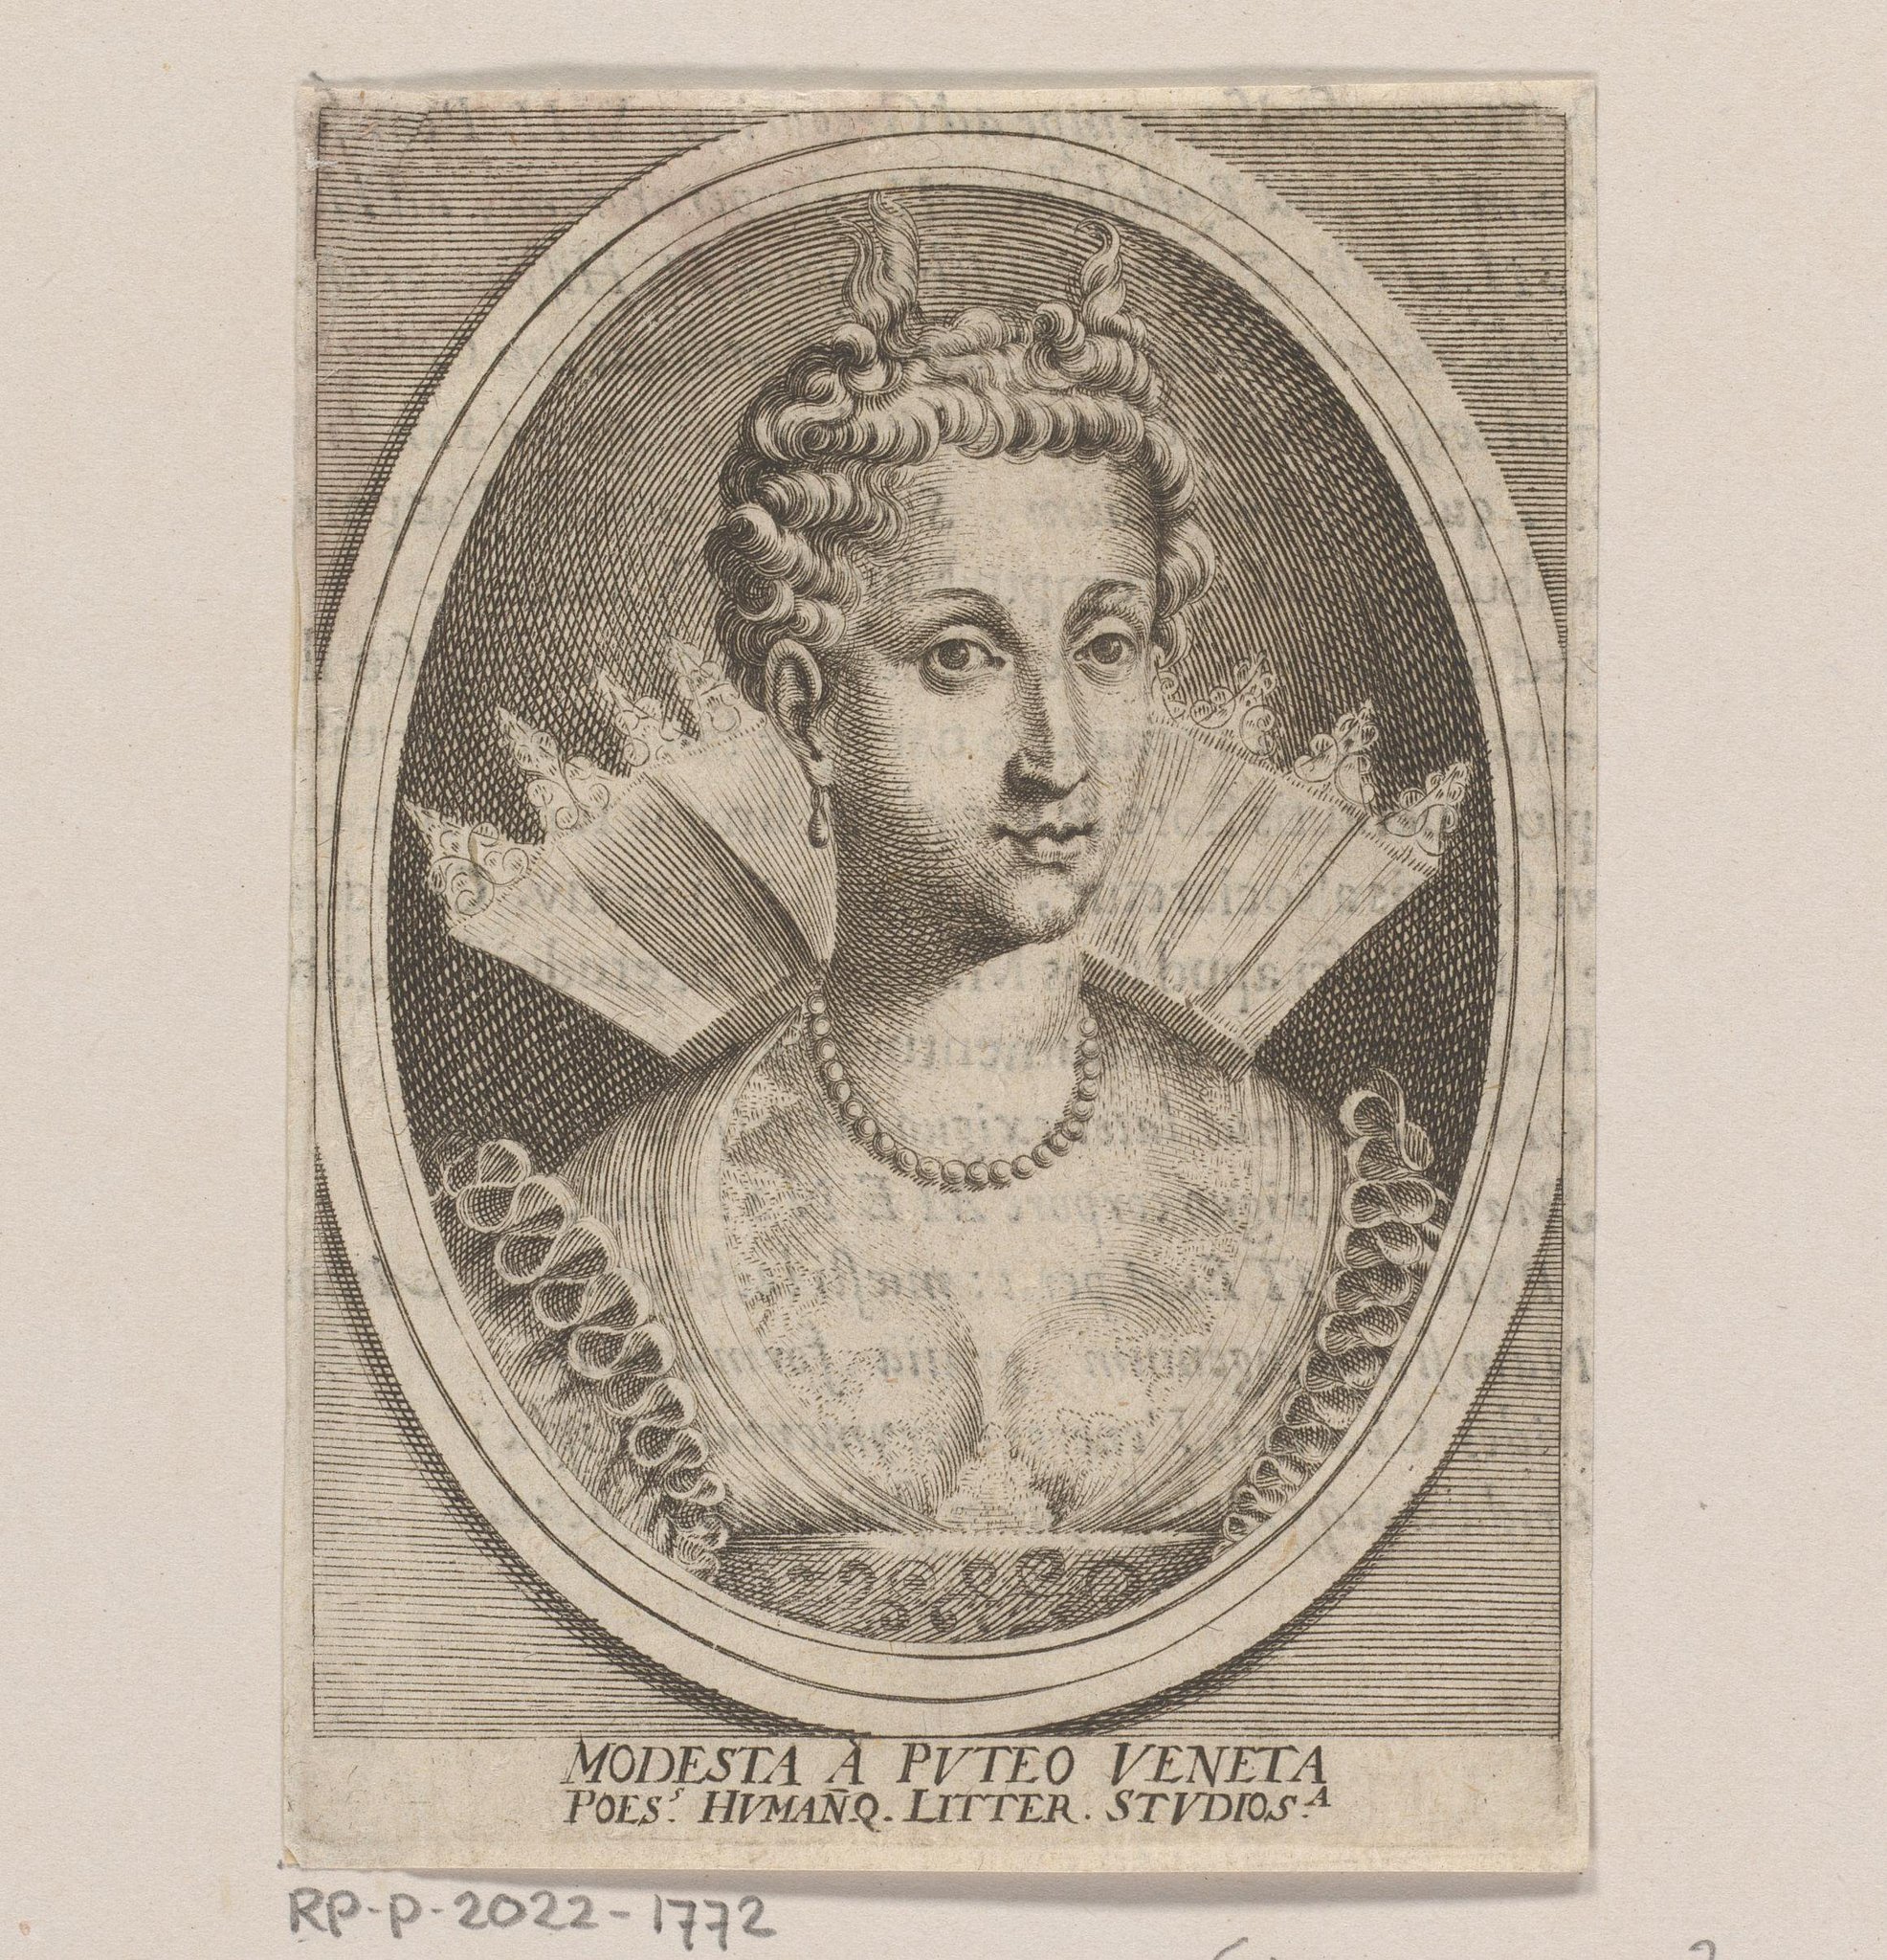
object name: book illustration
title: Portret van Modesta à Puteo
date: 1644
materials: paper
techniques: engraving, letterpress printing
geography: padua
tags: historical persons - bb - woman, portrait of a writer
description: Prent uit: Tomasini, Giacomo Filippo. Elogia virorum literis & sapientia illustrium ad viuum expressis imaginibus exornata. Padua: Sebastiano Sardi, 1644.